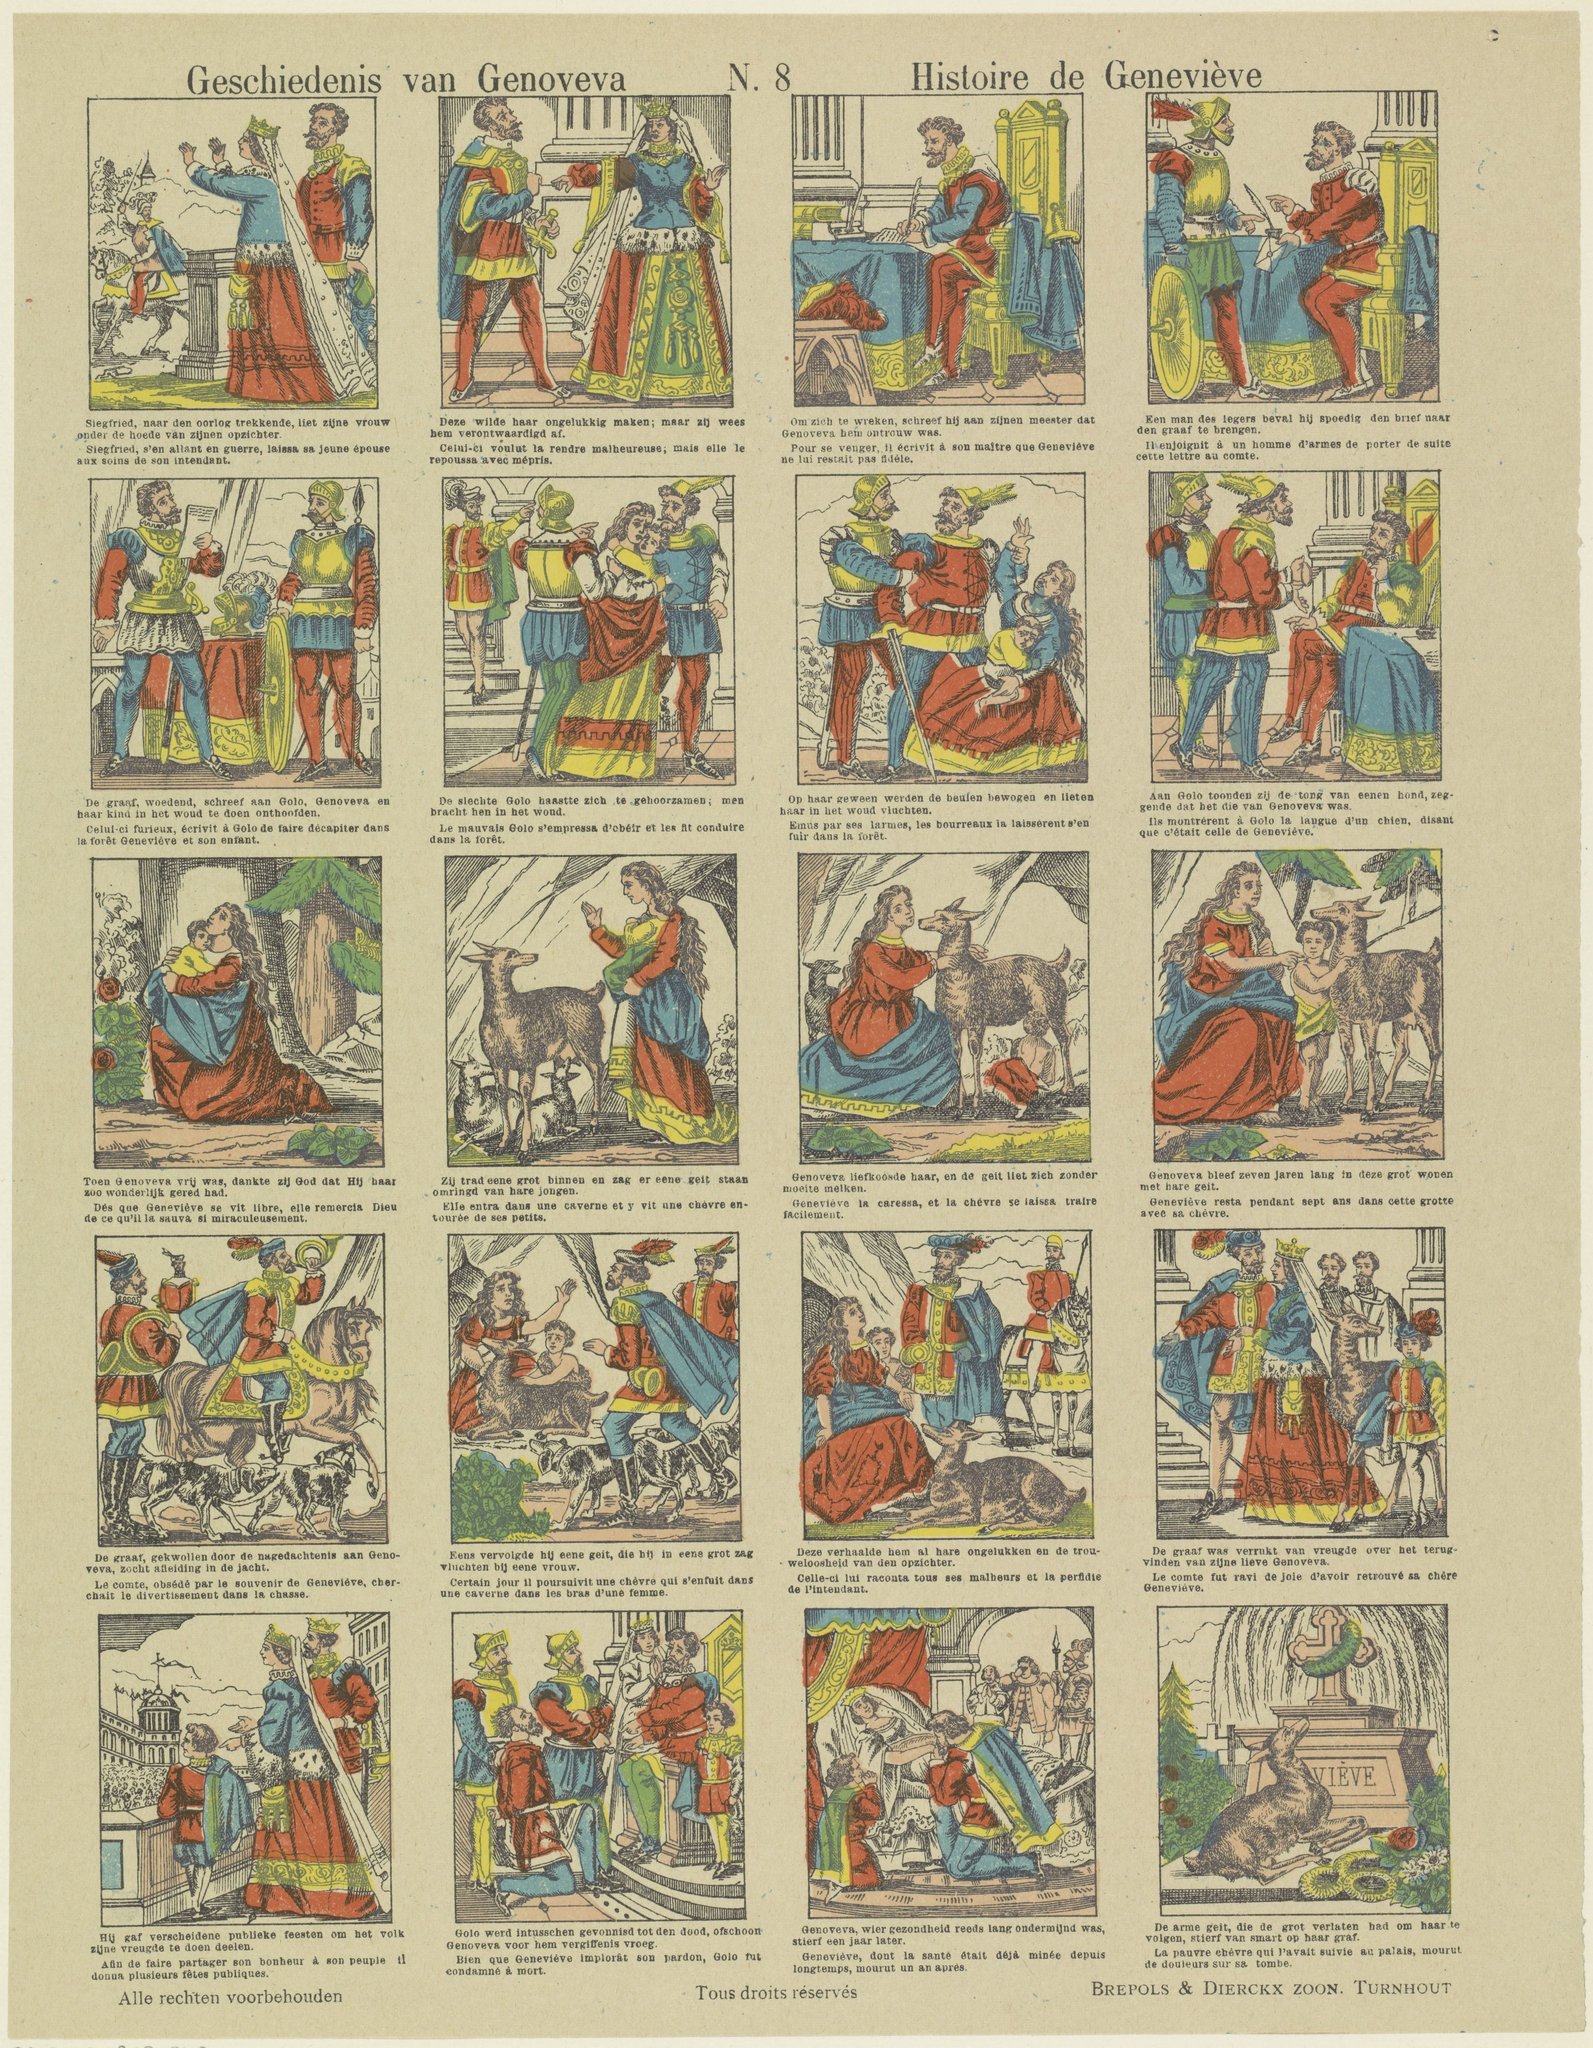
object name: popular print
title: Geschiedenis van Genoveva / Histoire de Geneviève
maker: Anonymous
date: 1833-1911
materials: paper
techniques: lithograph, letterpress printing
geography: turnhout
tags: genoveva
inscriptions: collector's mark: Lugt 2760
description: Blad met 20 voorstellingen over het leven van Genoveva van Brabant. Onder elke afbeelding een onderschrift in het Nederlands en in het Frans. Genummerd midden boven: N. 8.